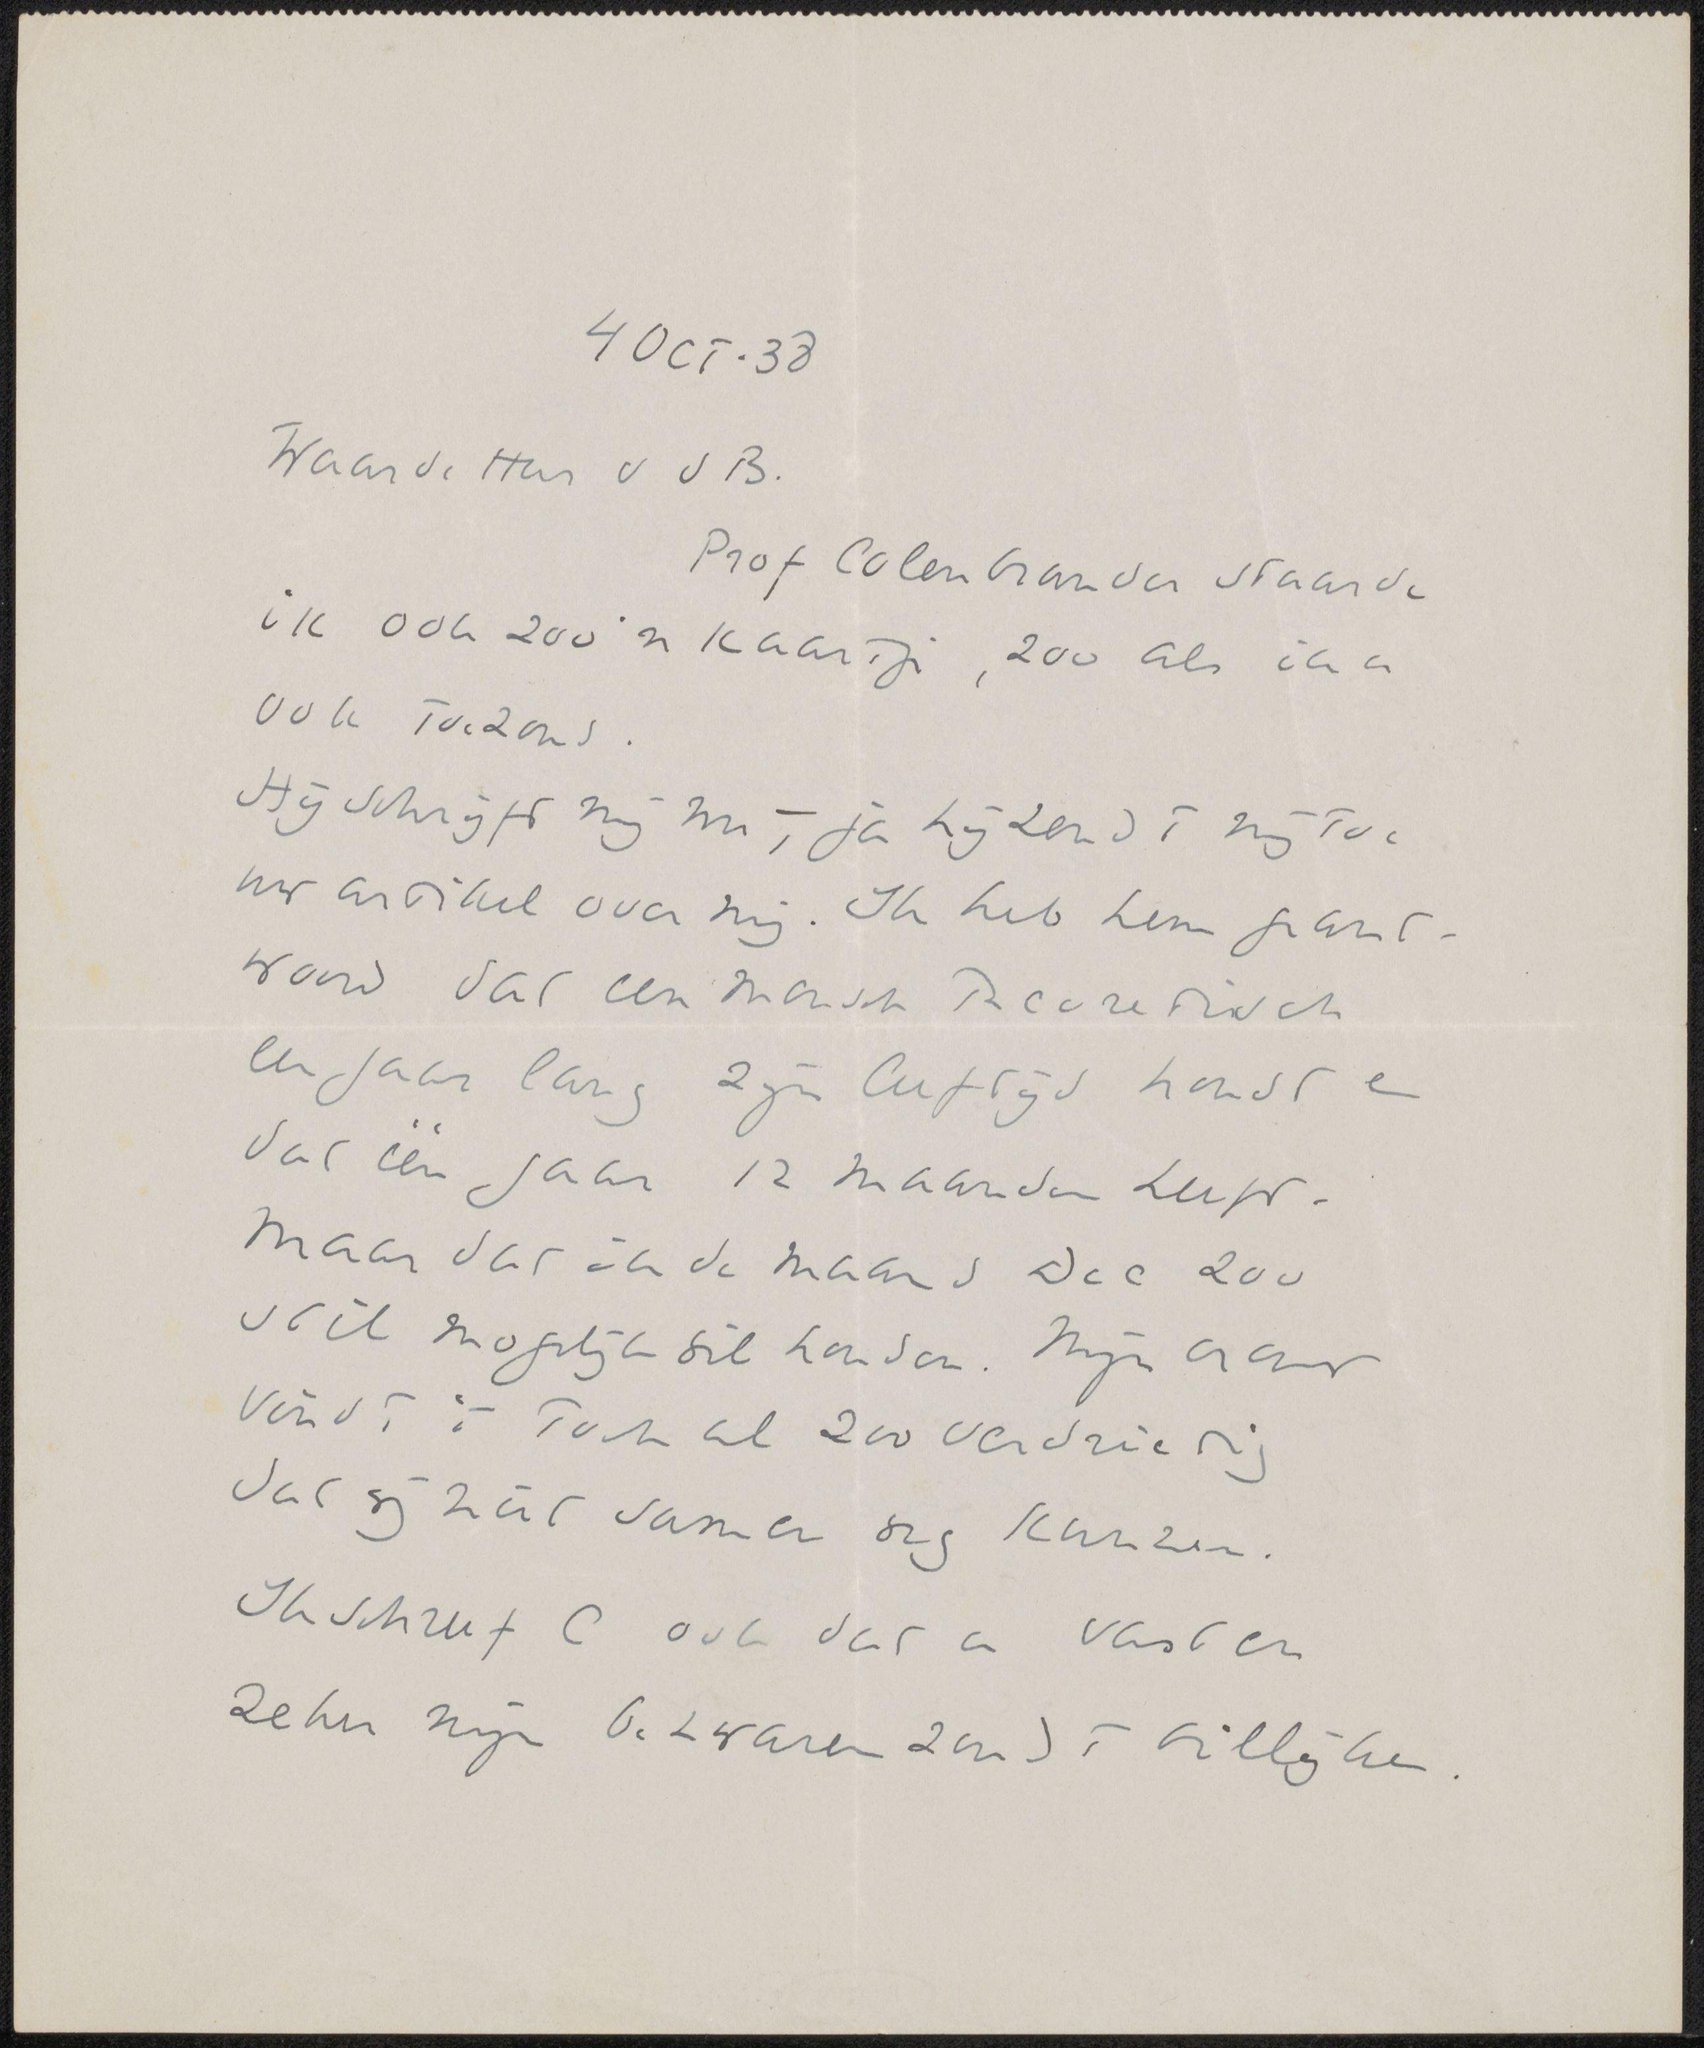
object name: letter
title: Brief aan A. van der Boom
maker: richard nicolaüs roland holst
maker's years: 1868-1938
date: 1938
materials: ink, paper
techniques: pen, writing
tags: a. van der boom, herman theodoor colenbrander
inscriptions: watermark, collector's mark: Lugt L.2228a